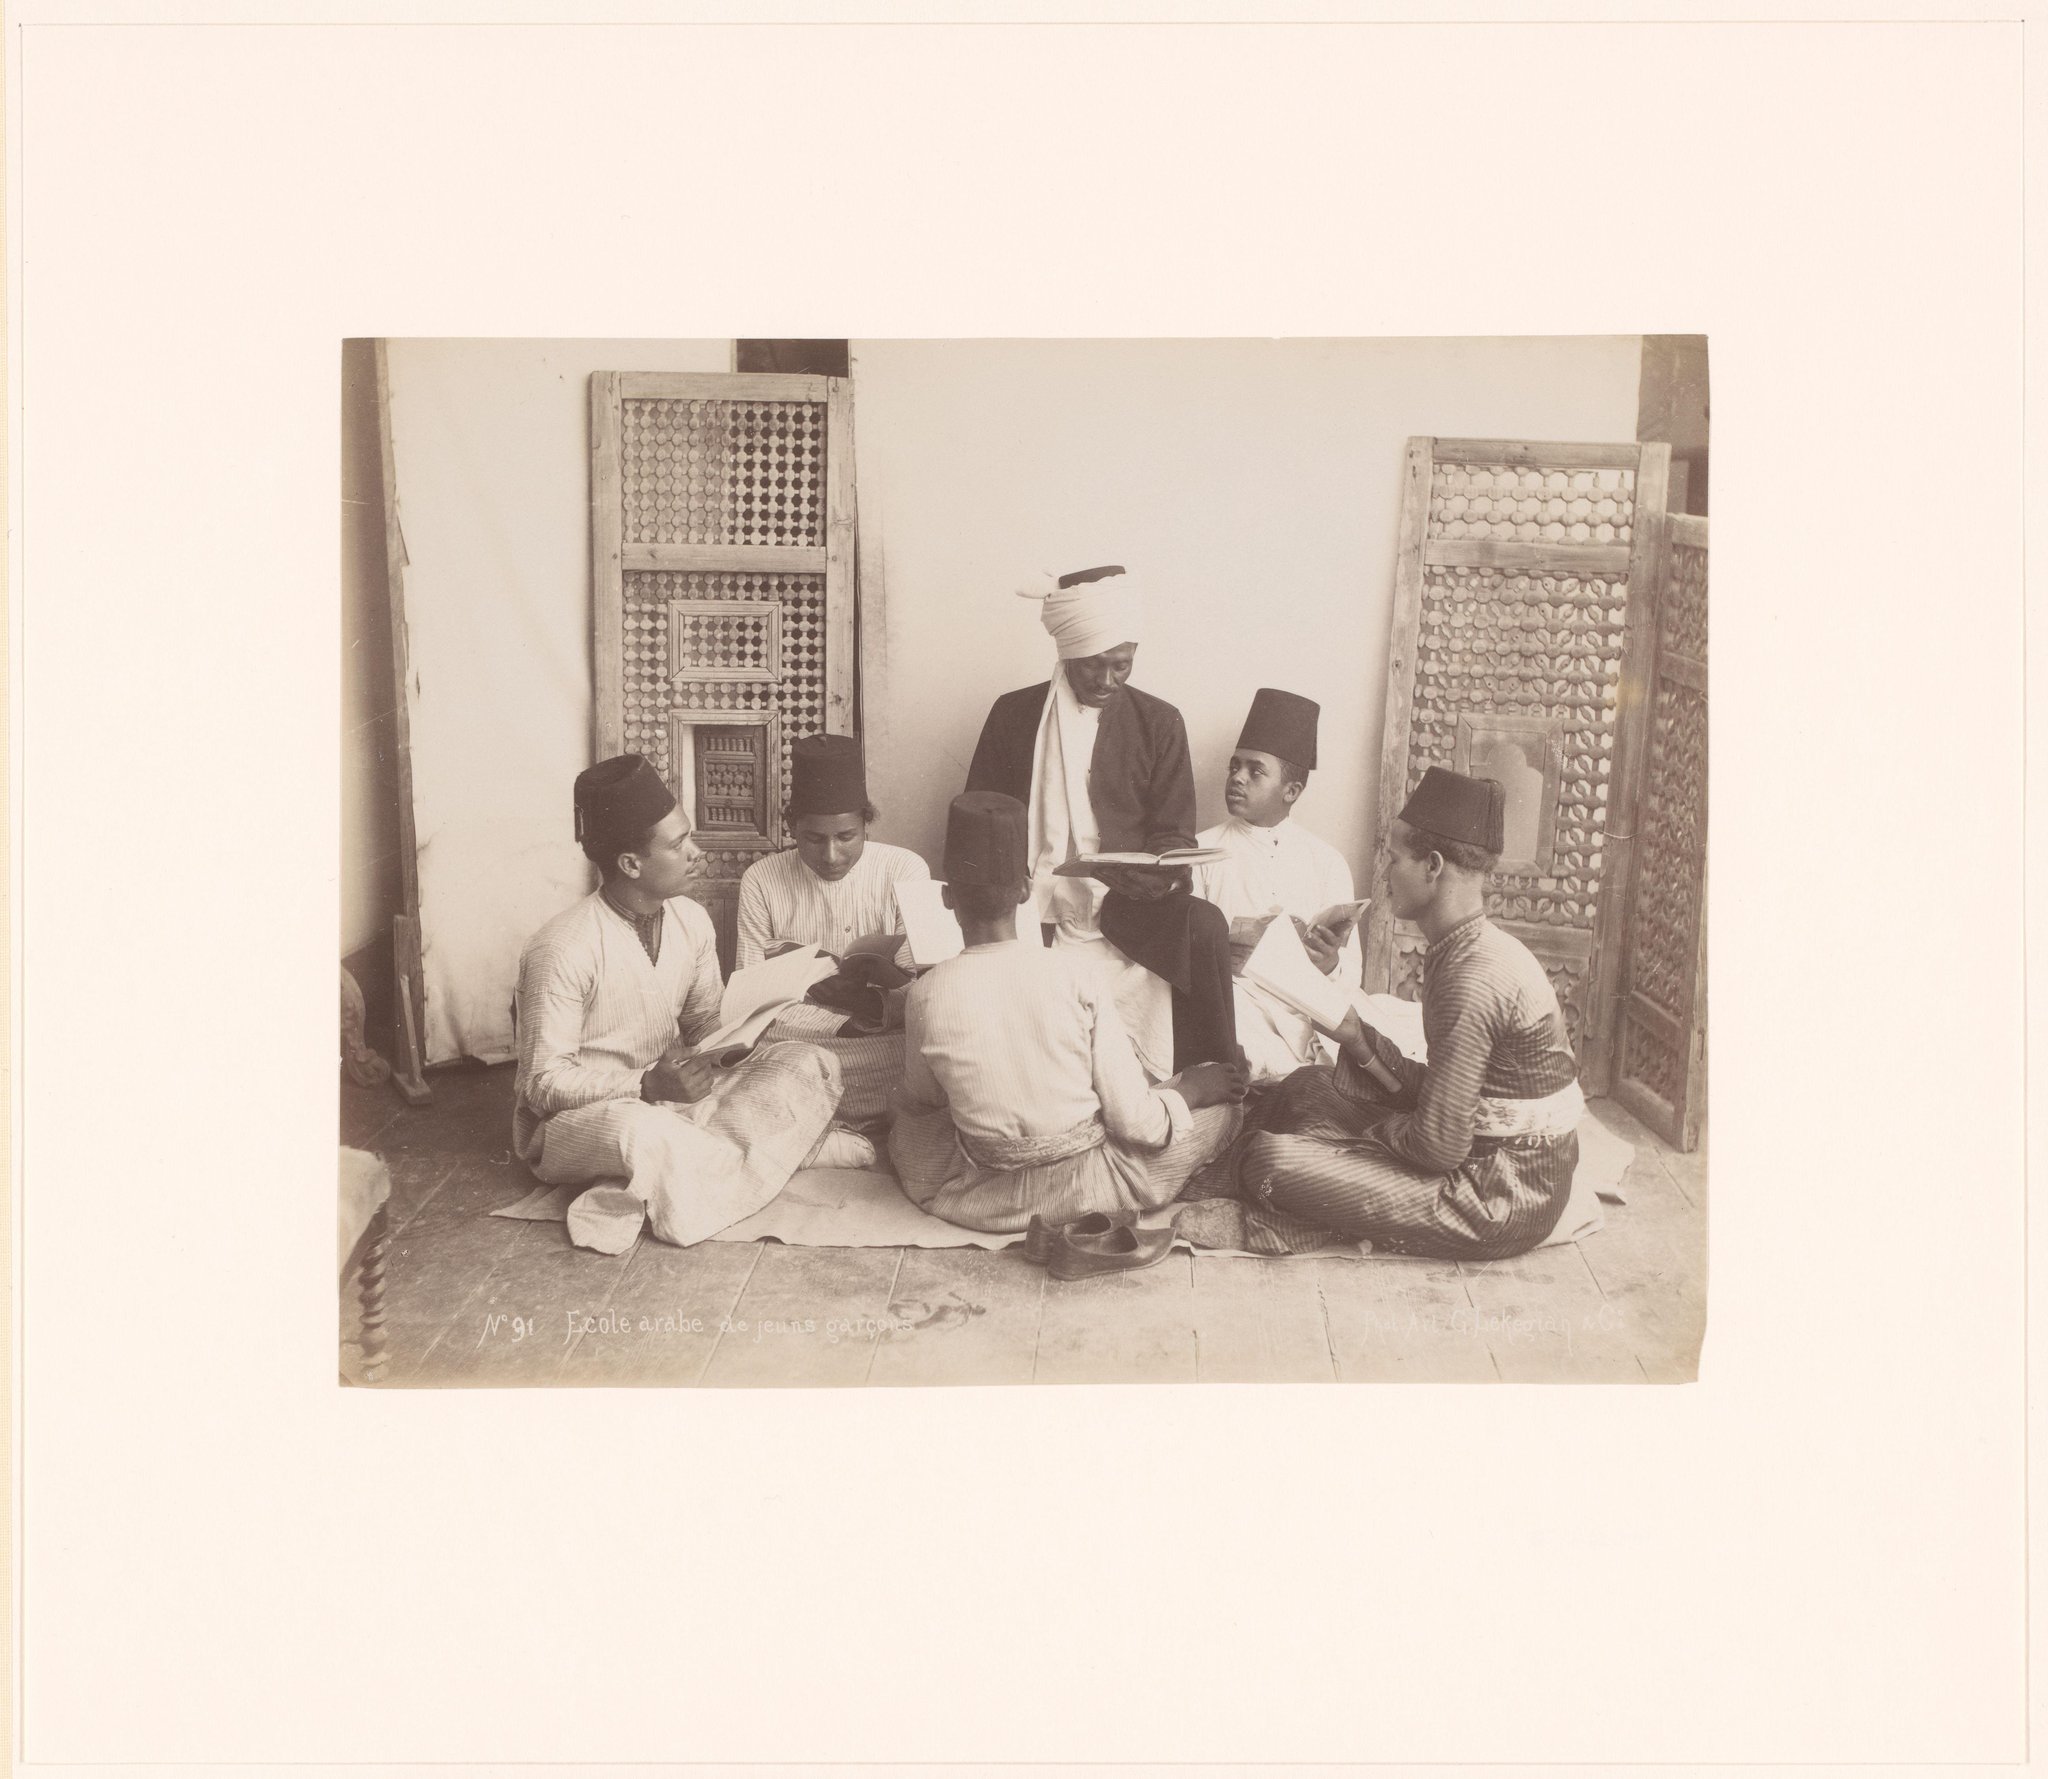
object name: photograph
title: Ecole Arabe de jeuns garçons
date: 1887-1900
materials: paper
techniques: albumen print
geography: middle east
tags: teacher and pupil (+ pupil)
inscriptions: number: ‘No 91’